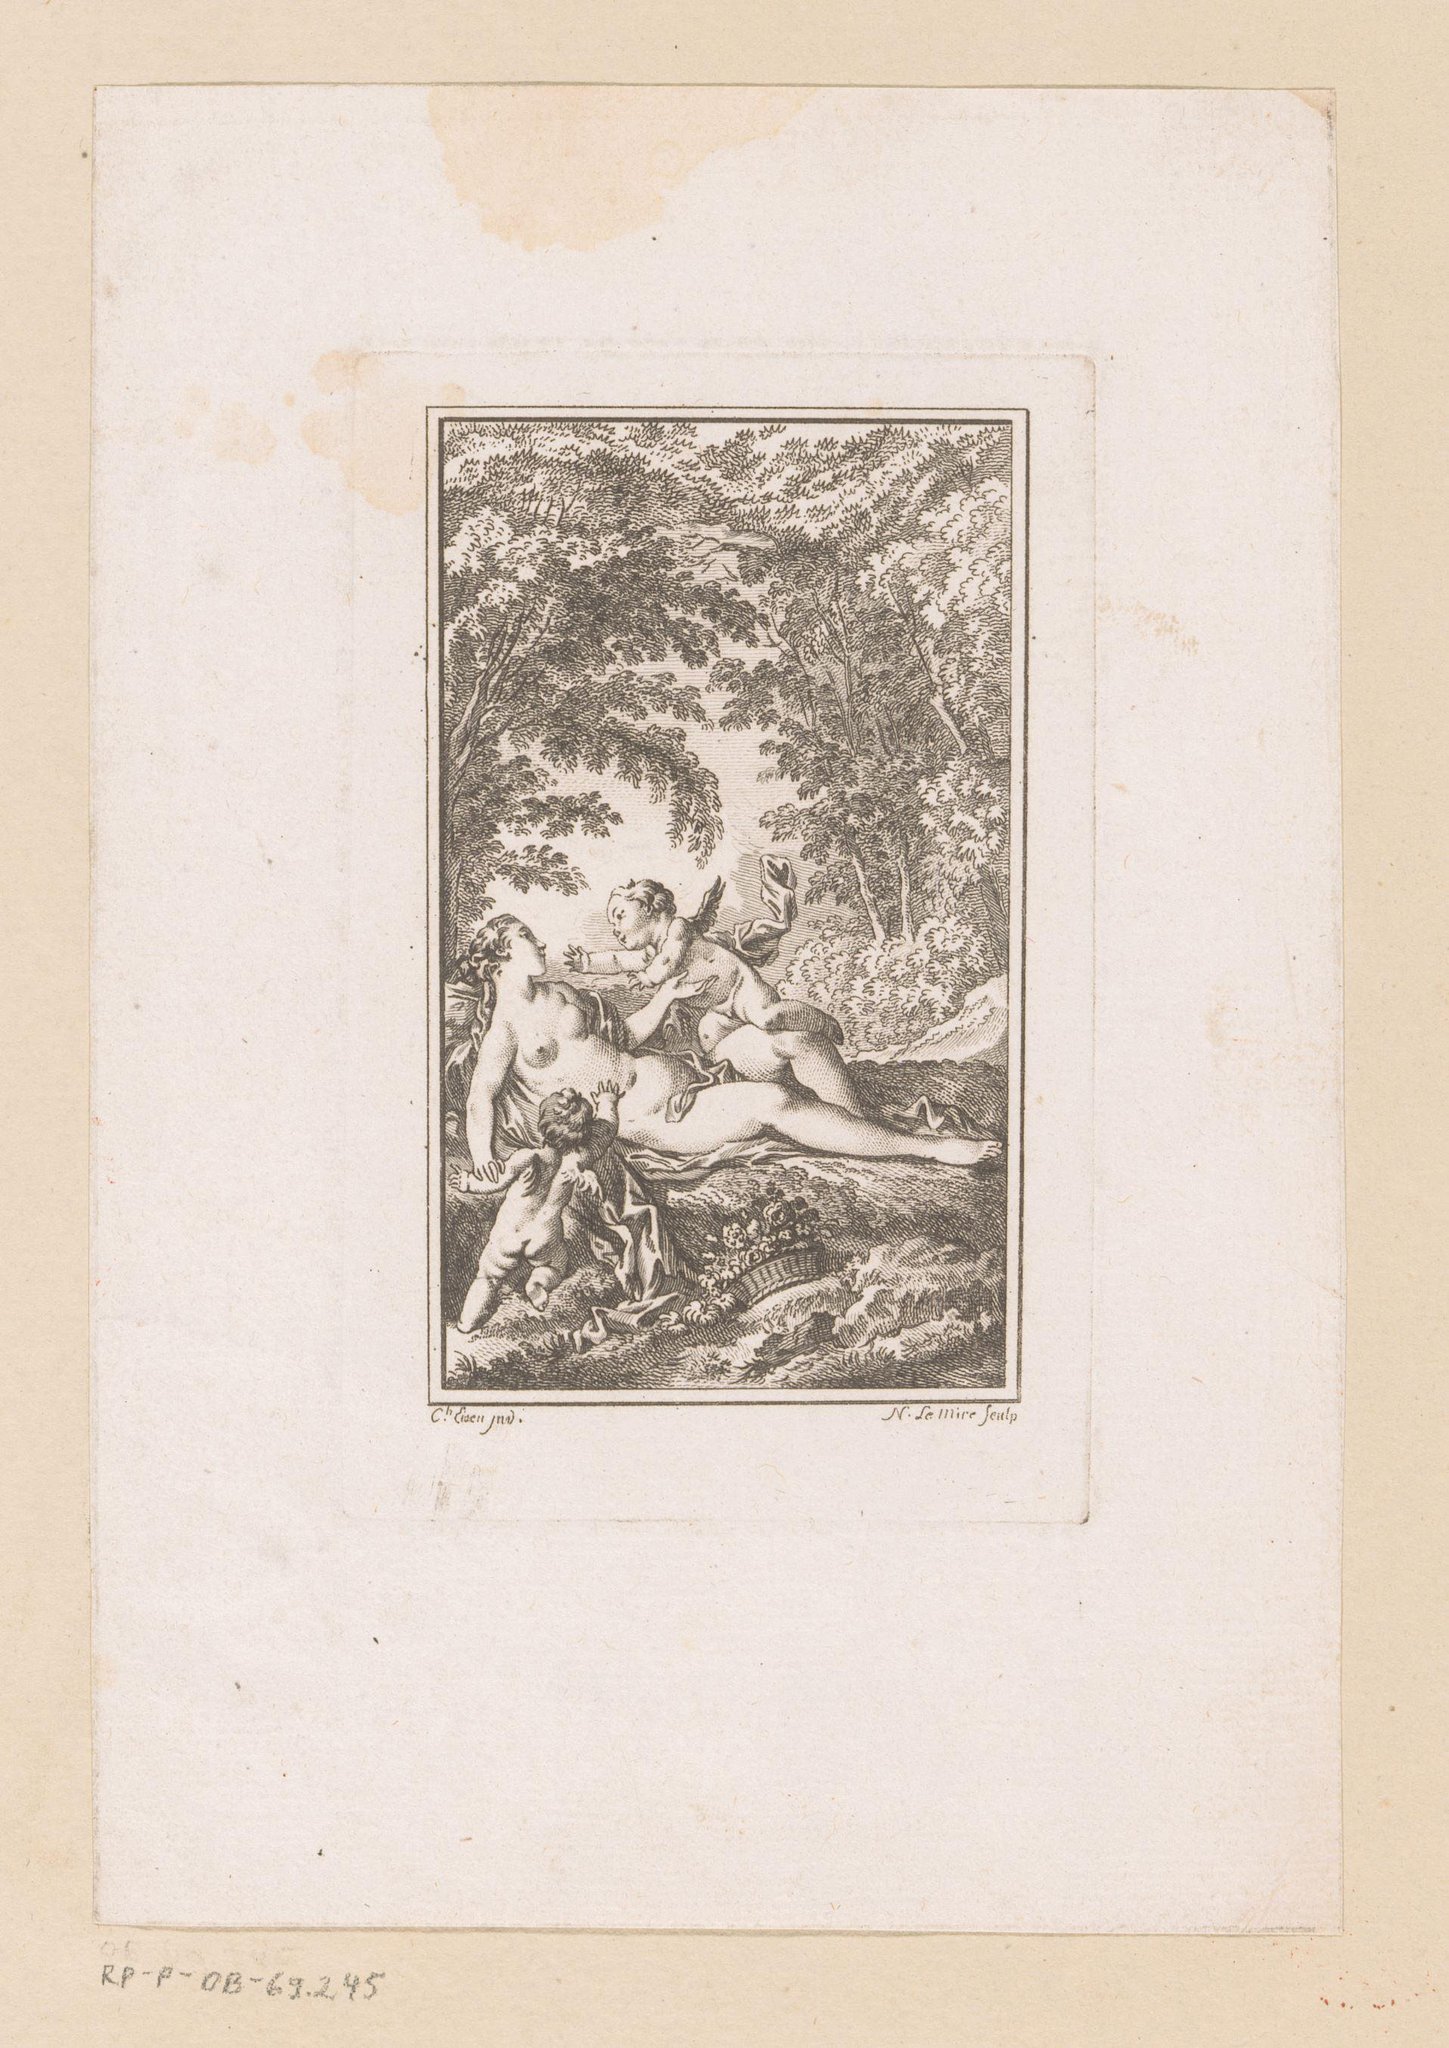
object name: print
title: Venus met twee putti in een bos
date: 1757-1767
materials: paper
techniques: etching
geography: france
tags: (story of) venus (aphrodite), cupids: 'amores', 'amoretti', 'putti'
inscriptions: collector's mark: Lugt 240